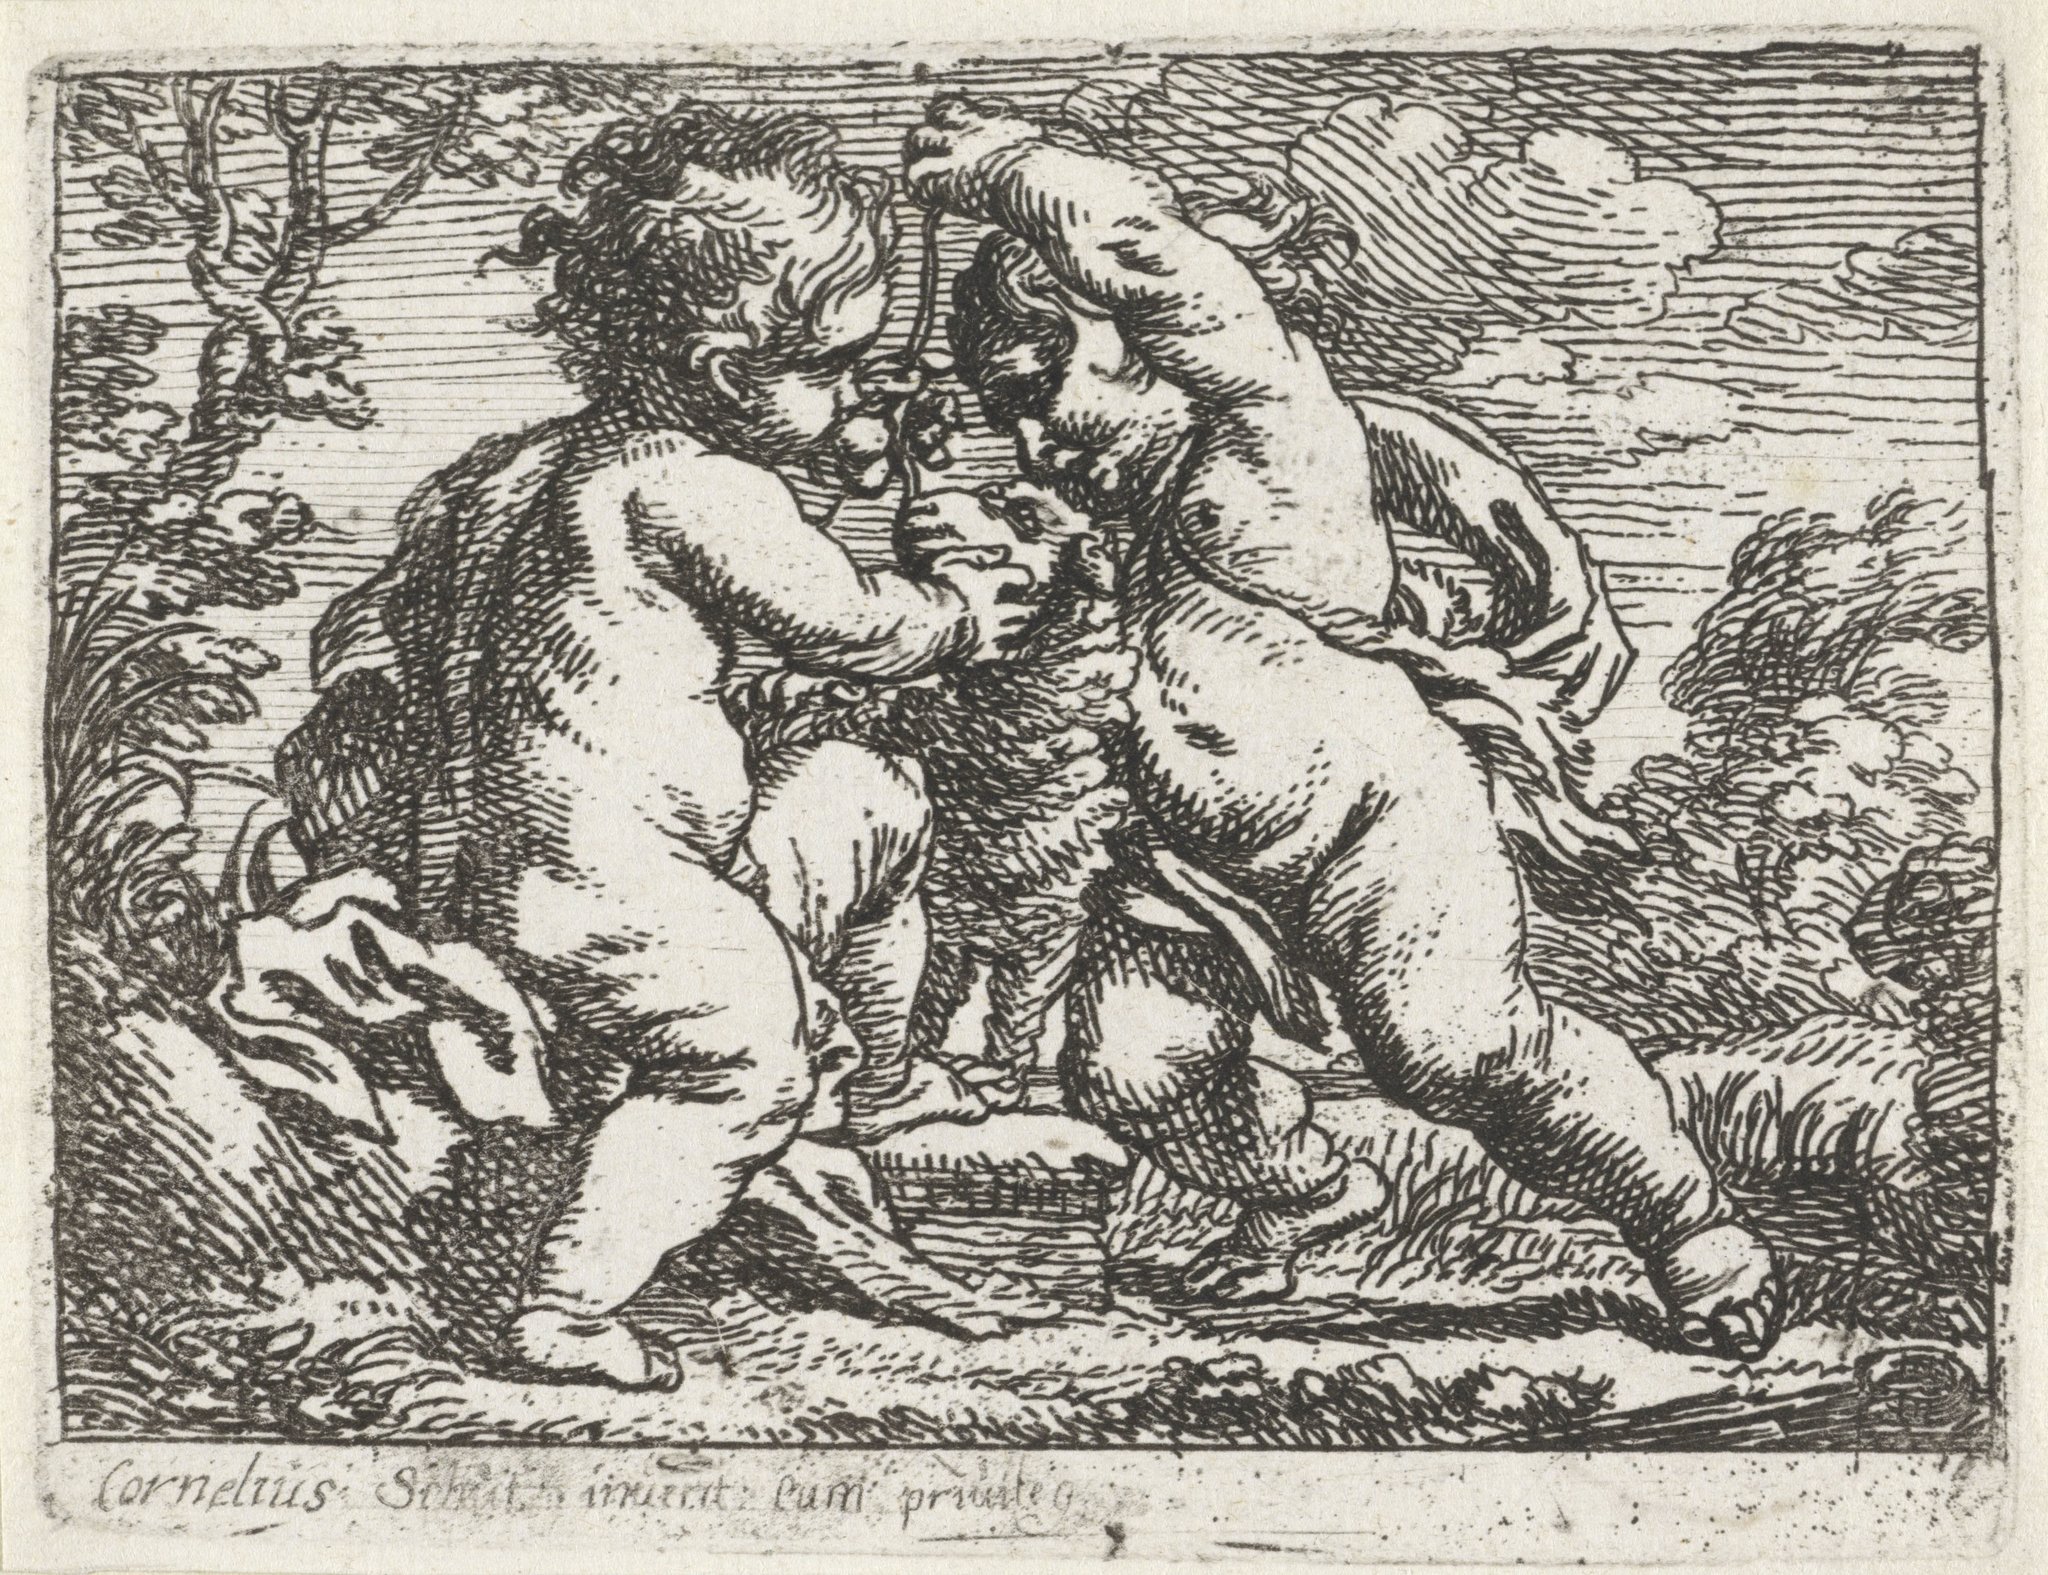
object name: print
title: Twee naakte kinderen met een lam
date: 1618-1655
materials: paper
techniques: etching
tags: lamb, child playing with animals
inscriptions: collector's mark: Lugt 240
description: Twee naakte kinderen in een landschap proberen een lam te voeren.